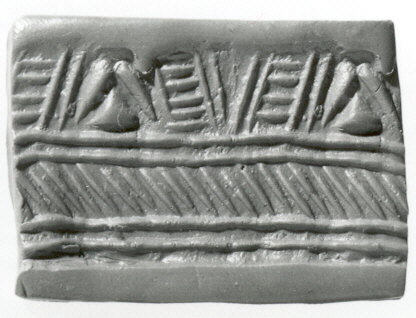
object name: cylinder seal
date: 3100-2900 BCE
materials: stone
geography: mesopotamia